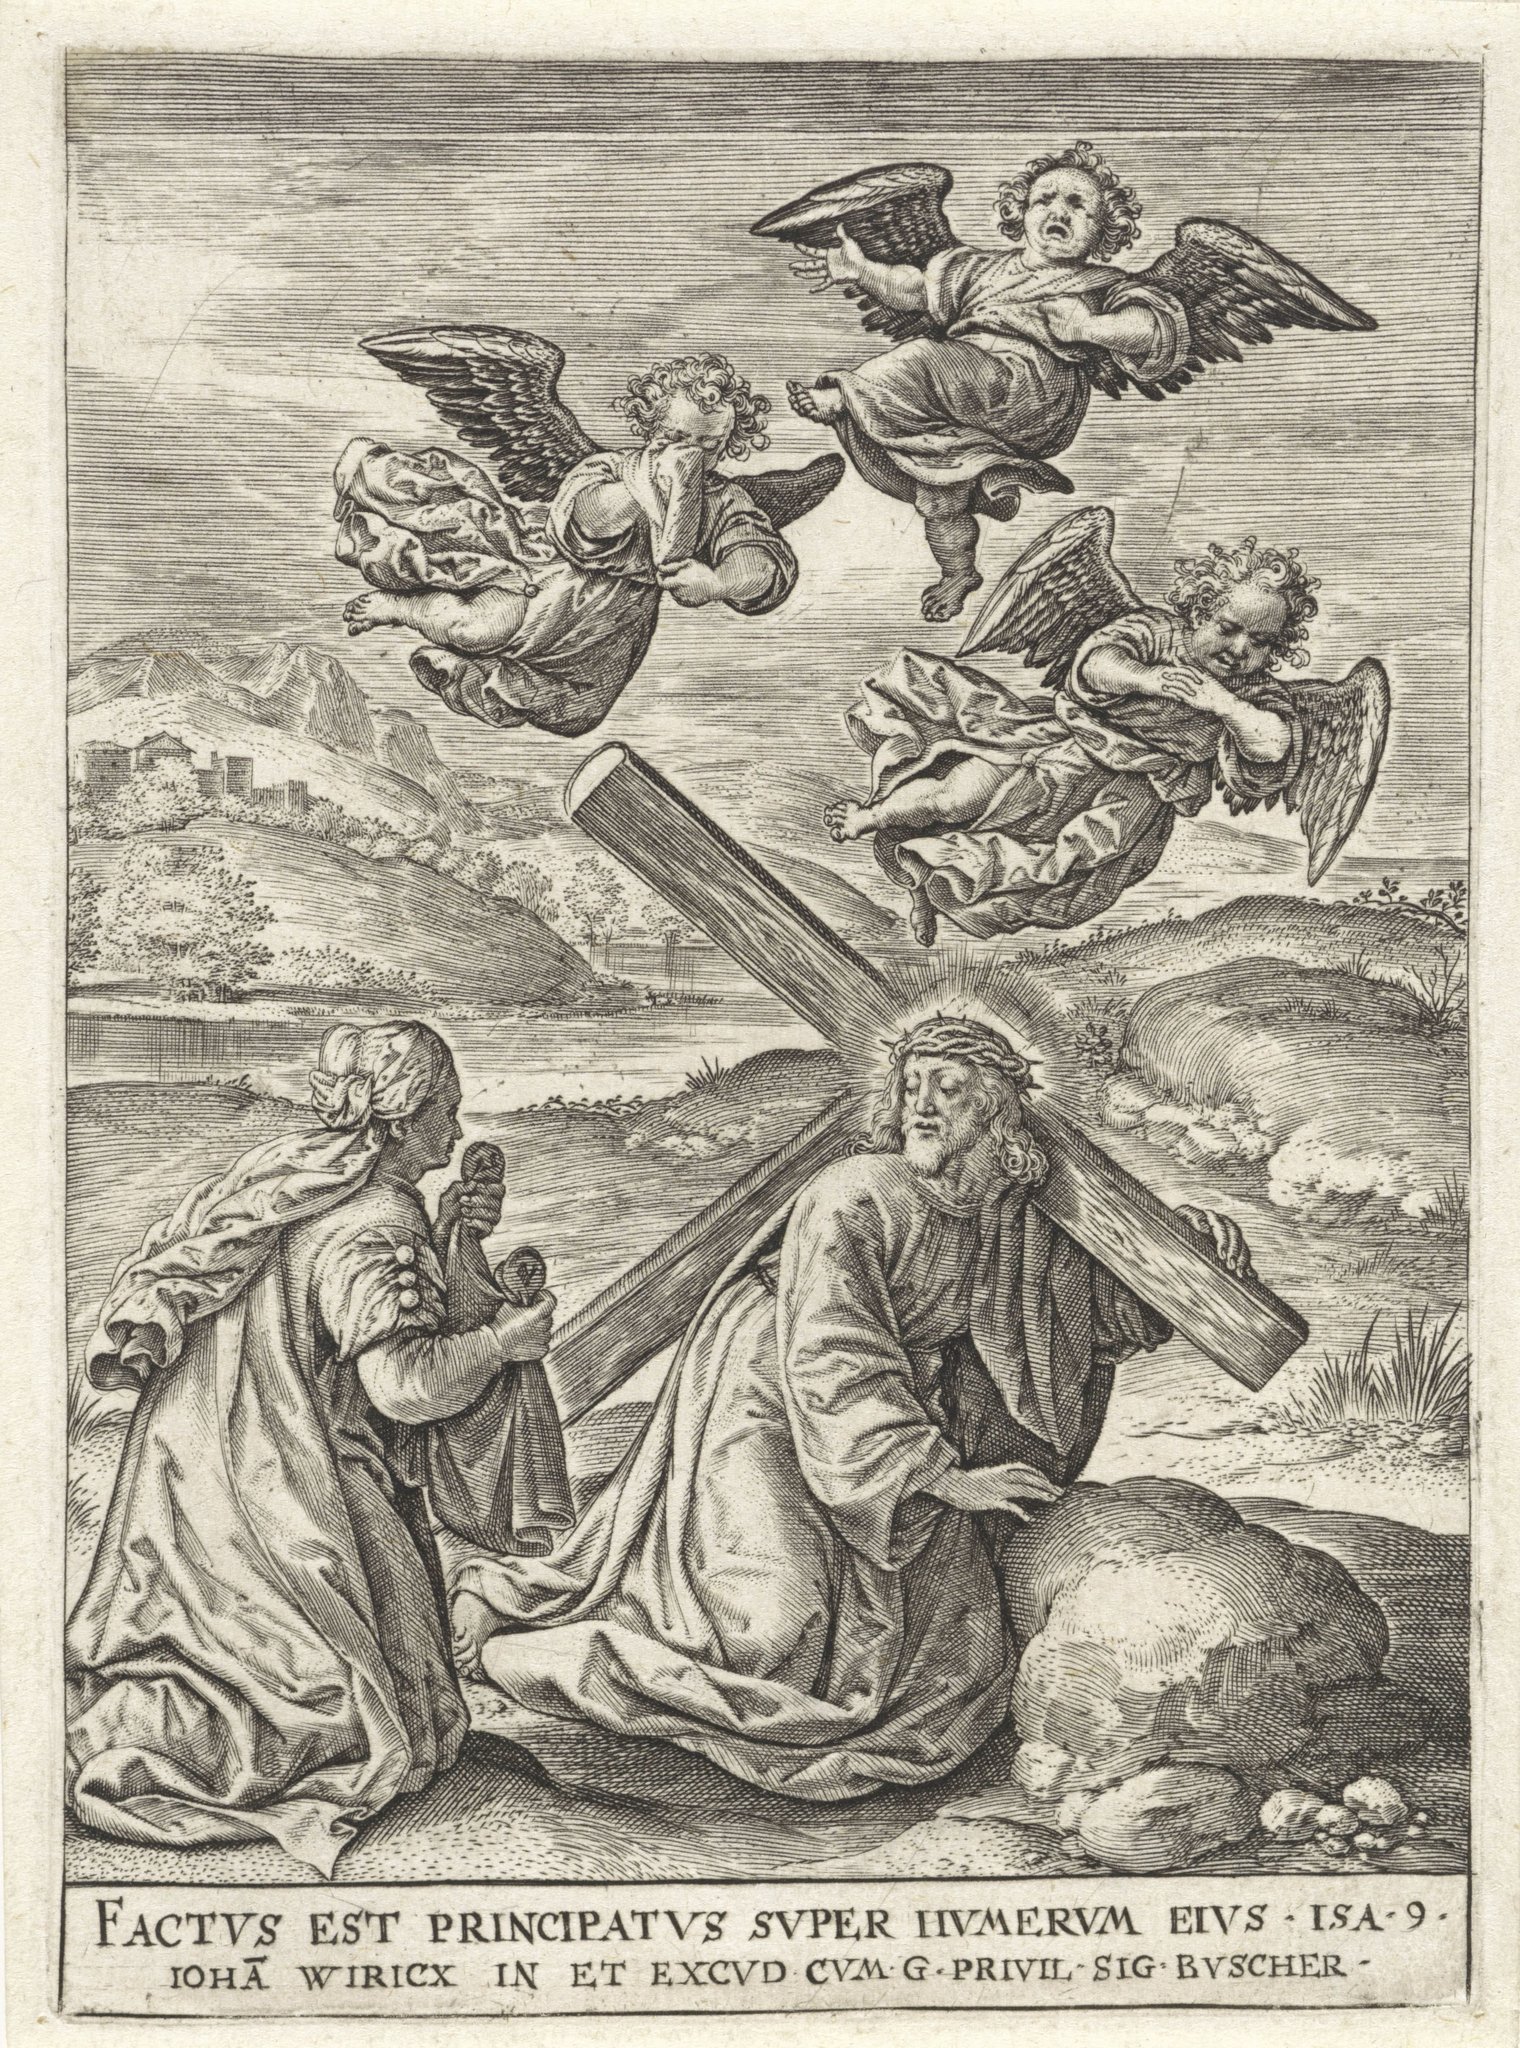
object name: print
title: Kruisdraging van Christus met Veronica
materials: paper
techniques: engraving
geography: antwerp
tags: christ collapsing ~ carrying of the cross, christ meets veronica, who has a cloth to wipe christ's face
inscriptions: collector's mark: Lugt 2228, collector's mark: Lugt 2542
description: Christus valt tijdens het dragen van zijn kruis naar Golgota. Veronica biedt aan het zweet van zijn gezicht te wissen met een doek. In de lucht vliegen drie wenende engelen. In de marge een Bijbelcitaat uit Jes. 9 in het Latijn.